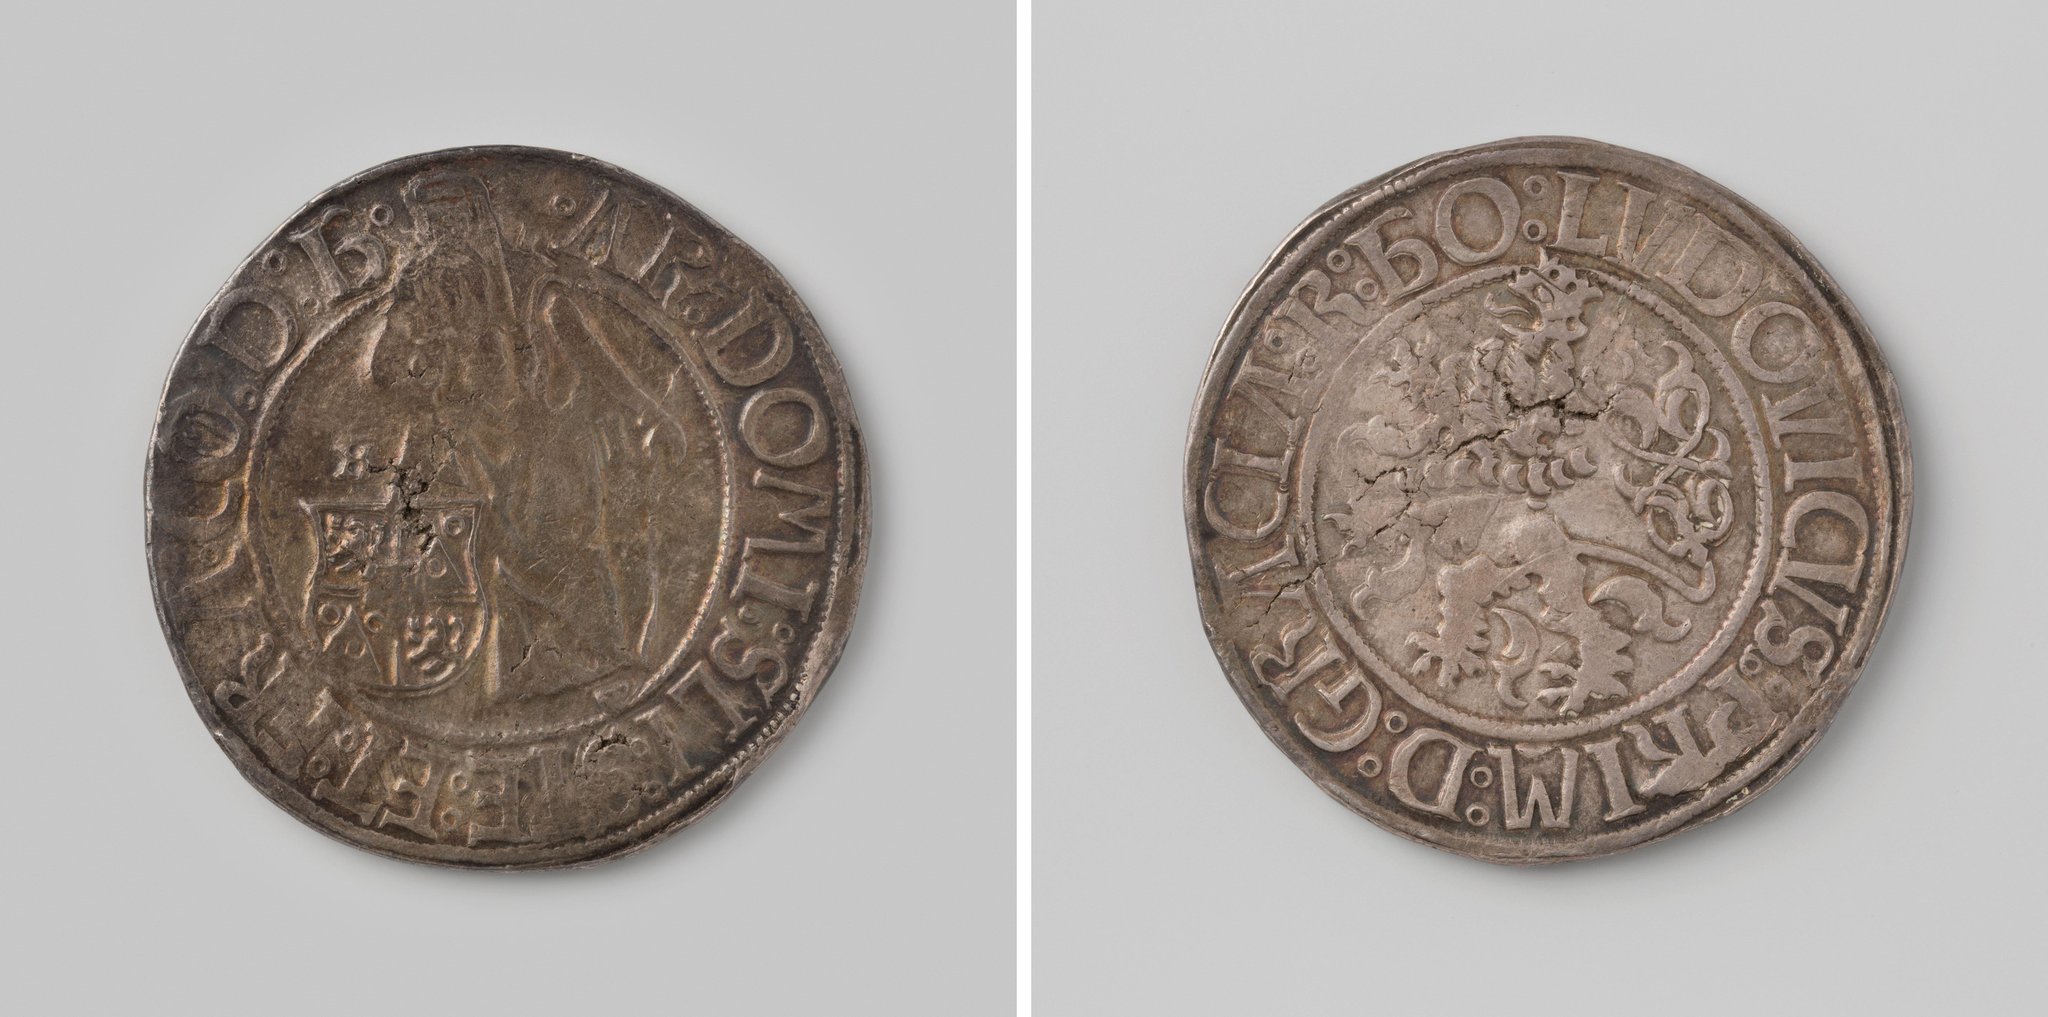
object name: taler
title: Taler uit Joachimsthal (Jáchymov) op naam van heer Stefan van Schlick (1516-1526)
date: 1519-1523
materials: silver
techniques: striking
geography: jàchymov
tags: earl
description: Zilveren munt. Voorzijde: tussen letters S en I de heilige Joachim, staande, van voren, met in linkerhand stok en recht een wapenschild. Keerzijde: klimmende leeuw met dubbele staart naar links.